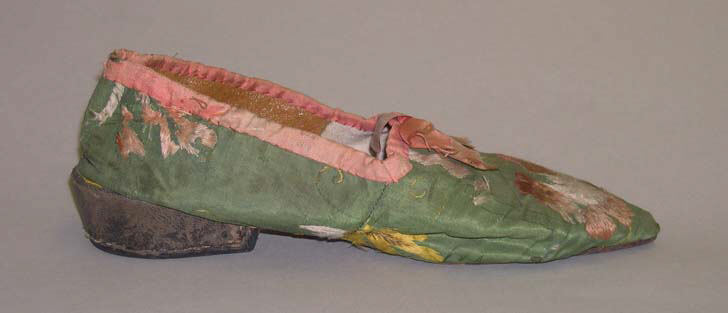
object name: shoe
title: Shoes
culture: italian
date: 1701-1800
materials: silk